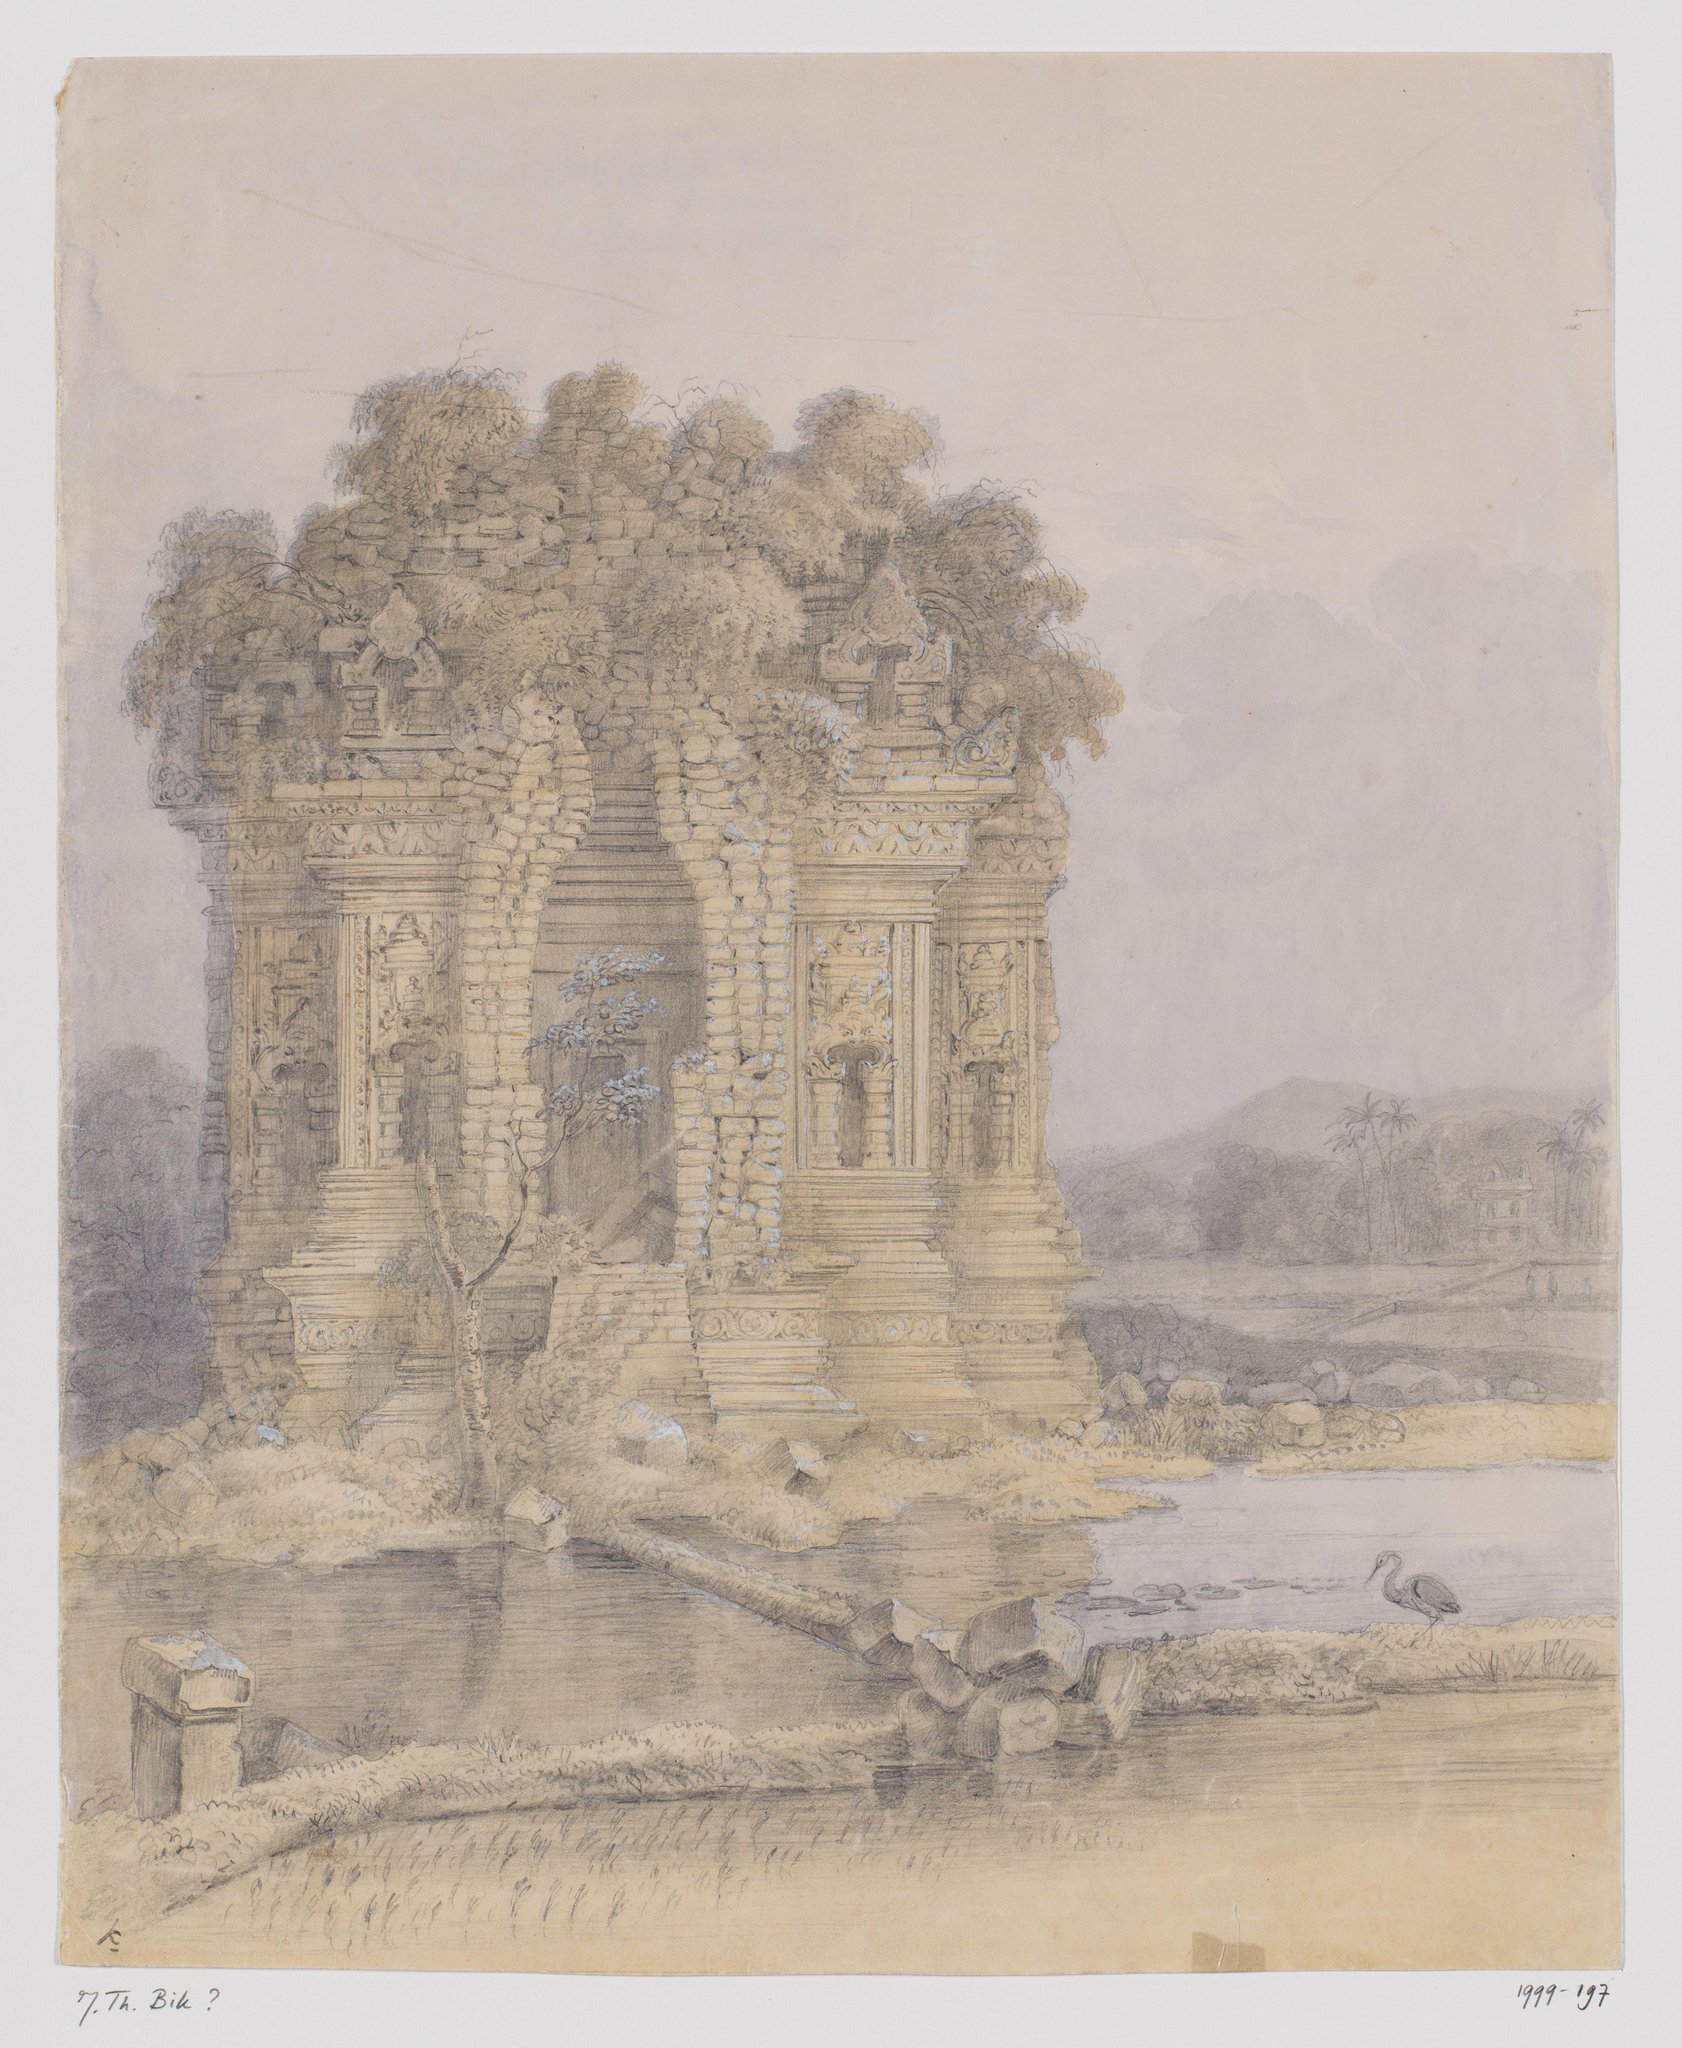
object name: drawing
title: Candi Kalasan, bij Yogyakarta, Midden-Java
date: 1817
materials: ink, paper, pencil, watercolor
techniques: brush, pen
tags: jogjakarta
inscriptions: annotation: ‘k; Djandie Kalie bening / te Kalasan. /Djocjakarta’